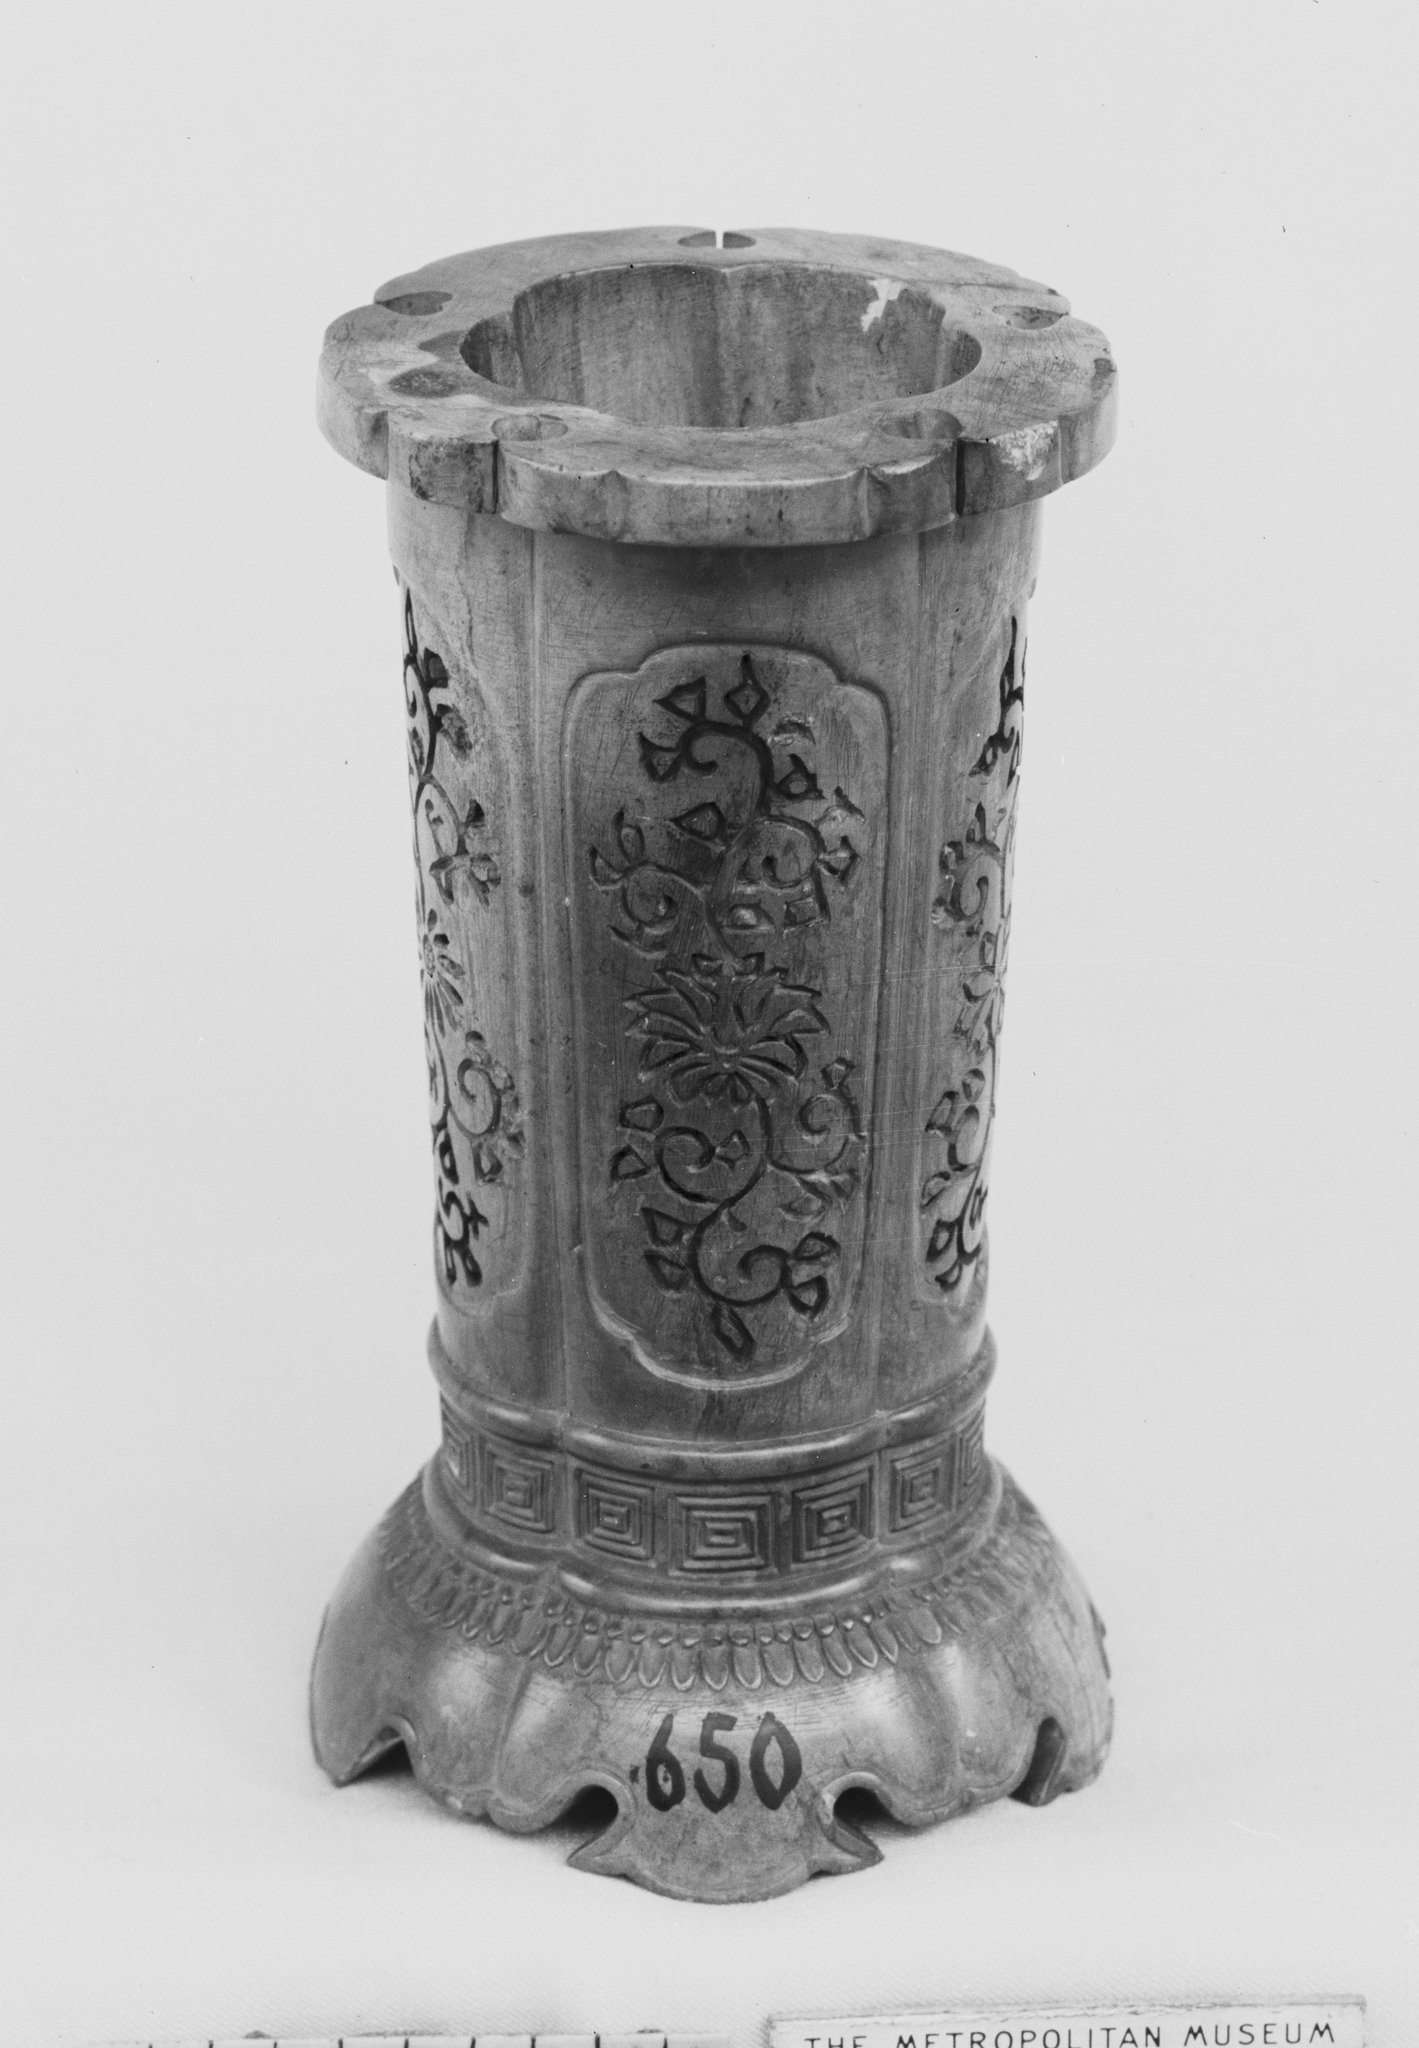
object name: flower vase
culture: chinese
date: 1736-1795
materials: jade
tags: flowers